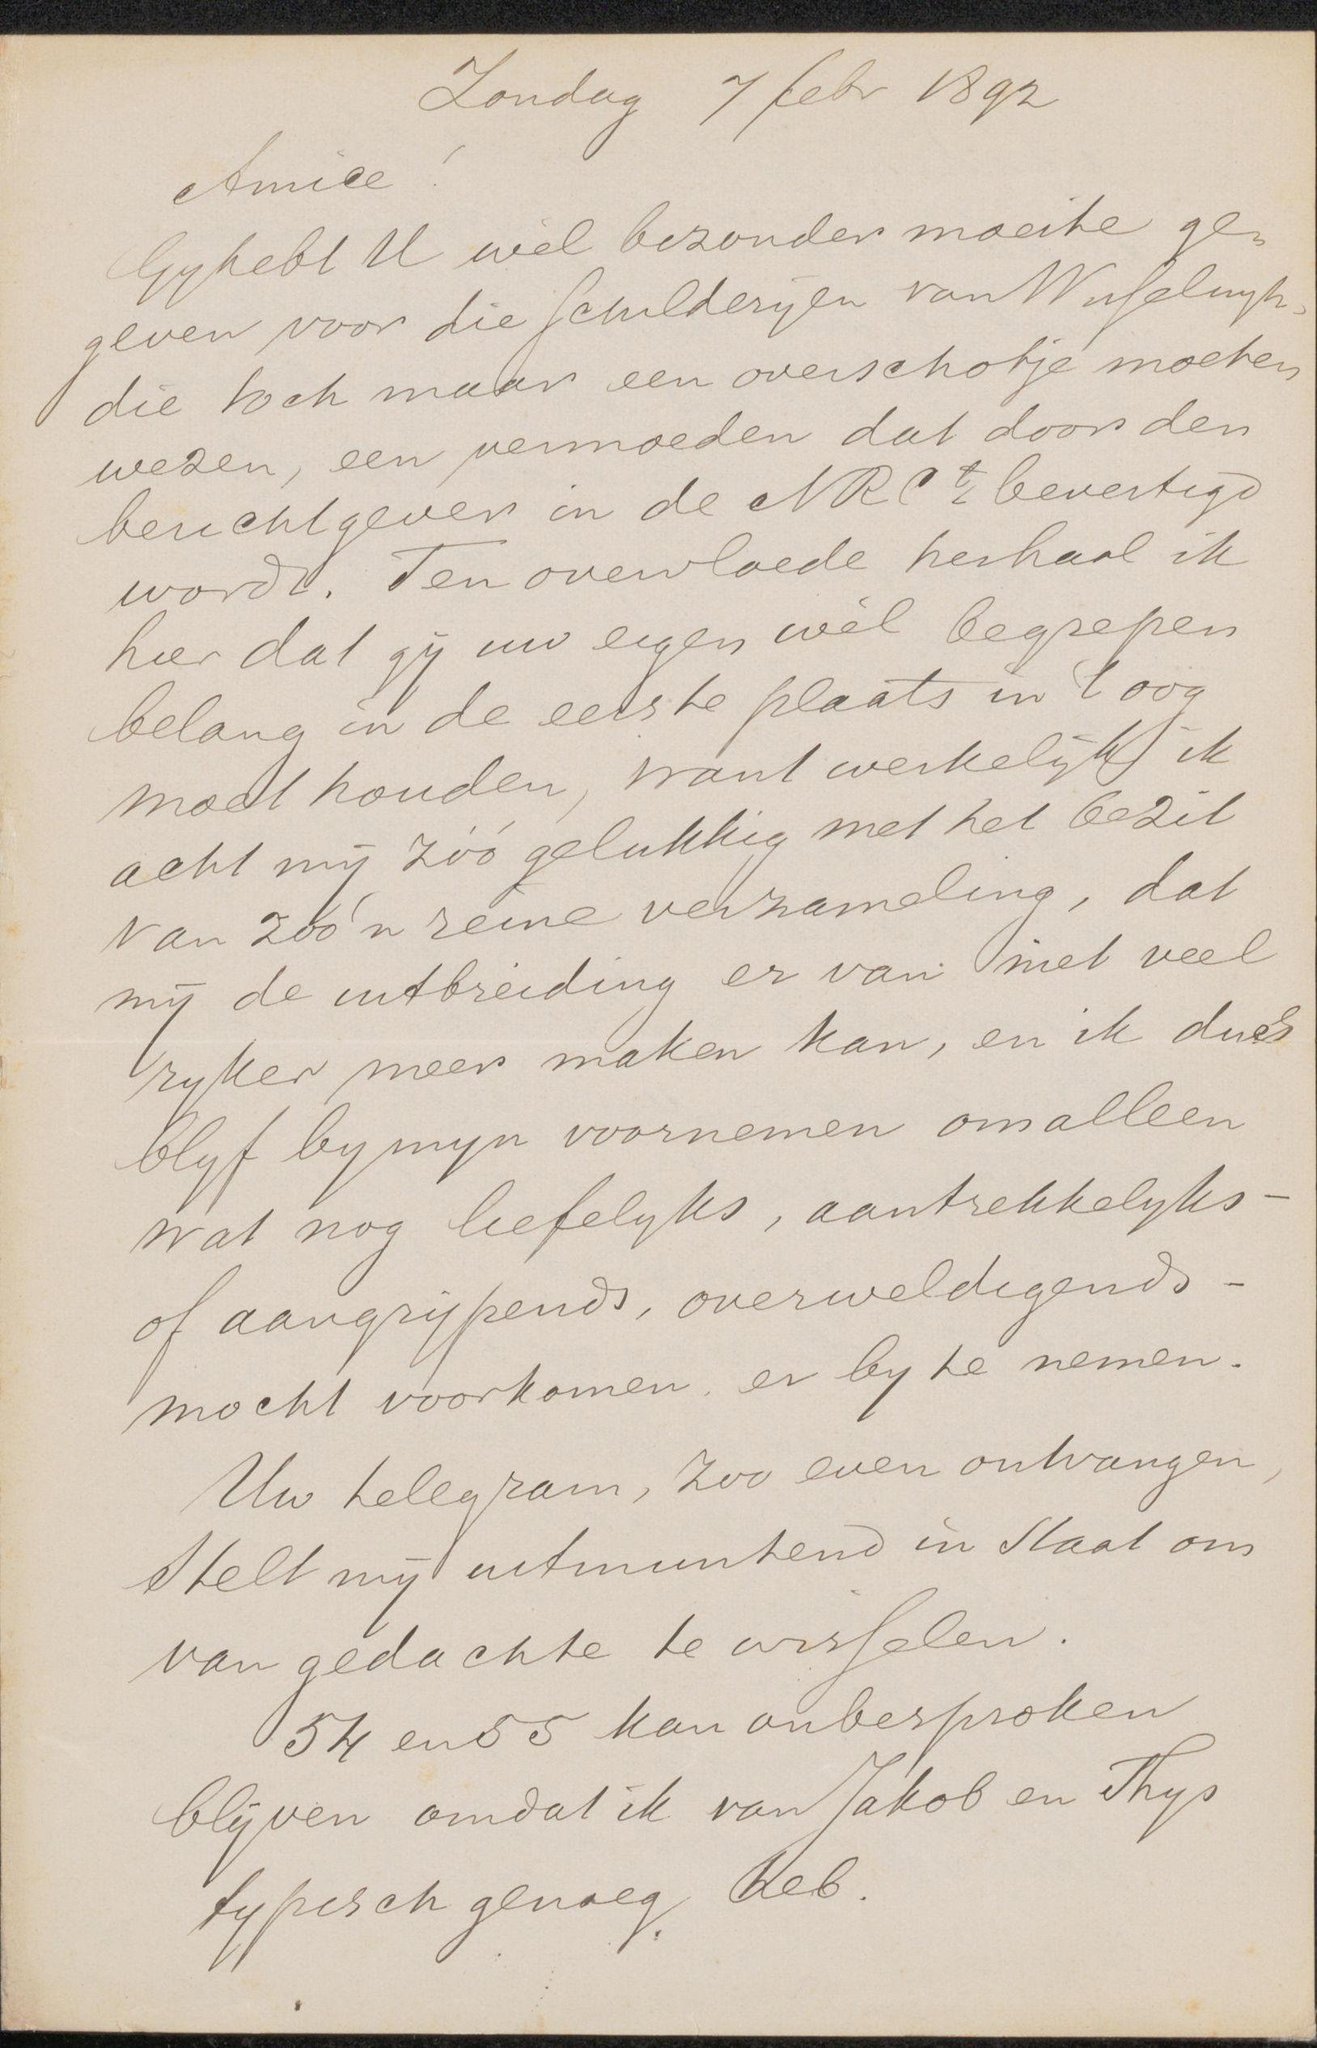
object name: letter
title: Brief aan Jan Veth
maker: martinus cornelis lebret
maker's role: verzamelaar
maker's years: 1833-1894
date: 1892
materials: ink, paper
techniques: pen, writing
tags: rotterdam, george hendrik breitner, dordrecht, amsterdam, painter, print maker, draughtsman, designer, jan veth, london, matthijs maris, jacob maris, the hague, tony lodewijk george offermans, brussels, françois duchatel, hendrik jan van wisselingh, painting (including book-illumination, miniature-painting), art collecting, historical persons (portraits and scenes from the life)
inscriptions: collector's mark: ‘RPK’